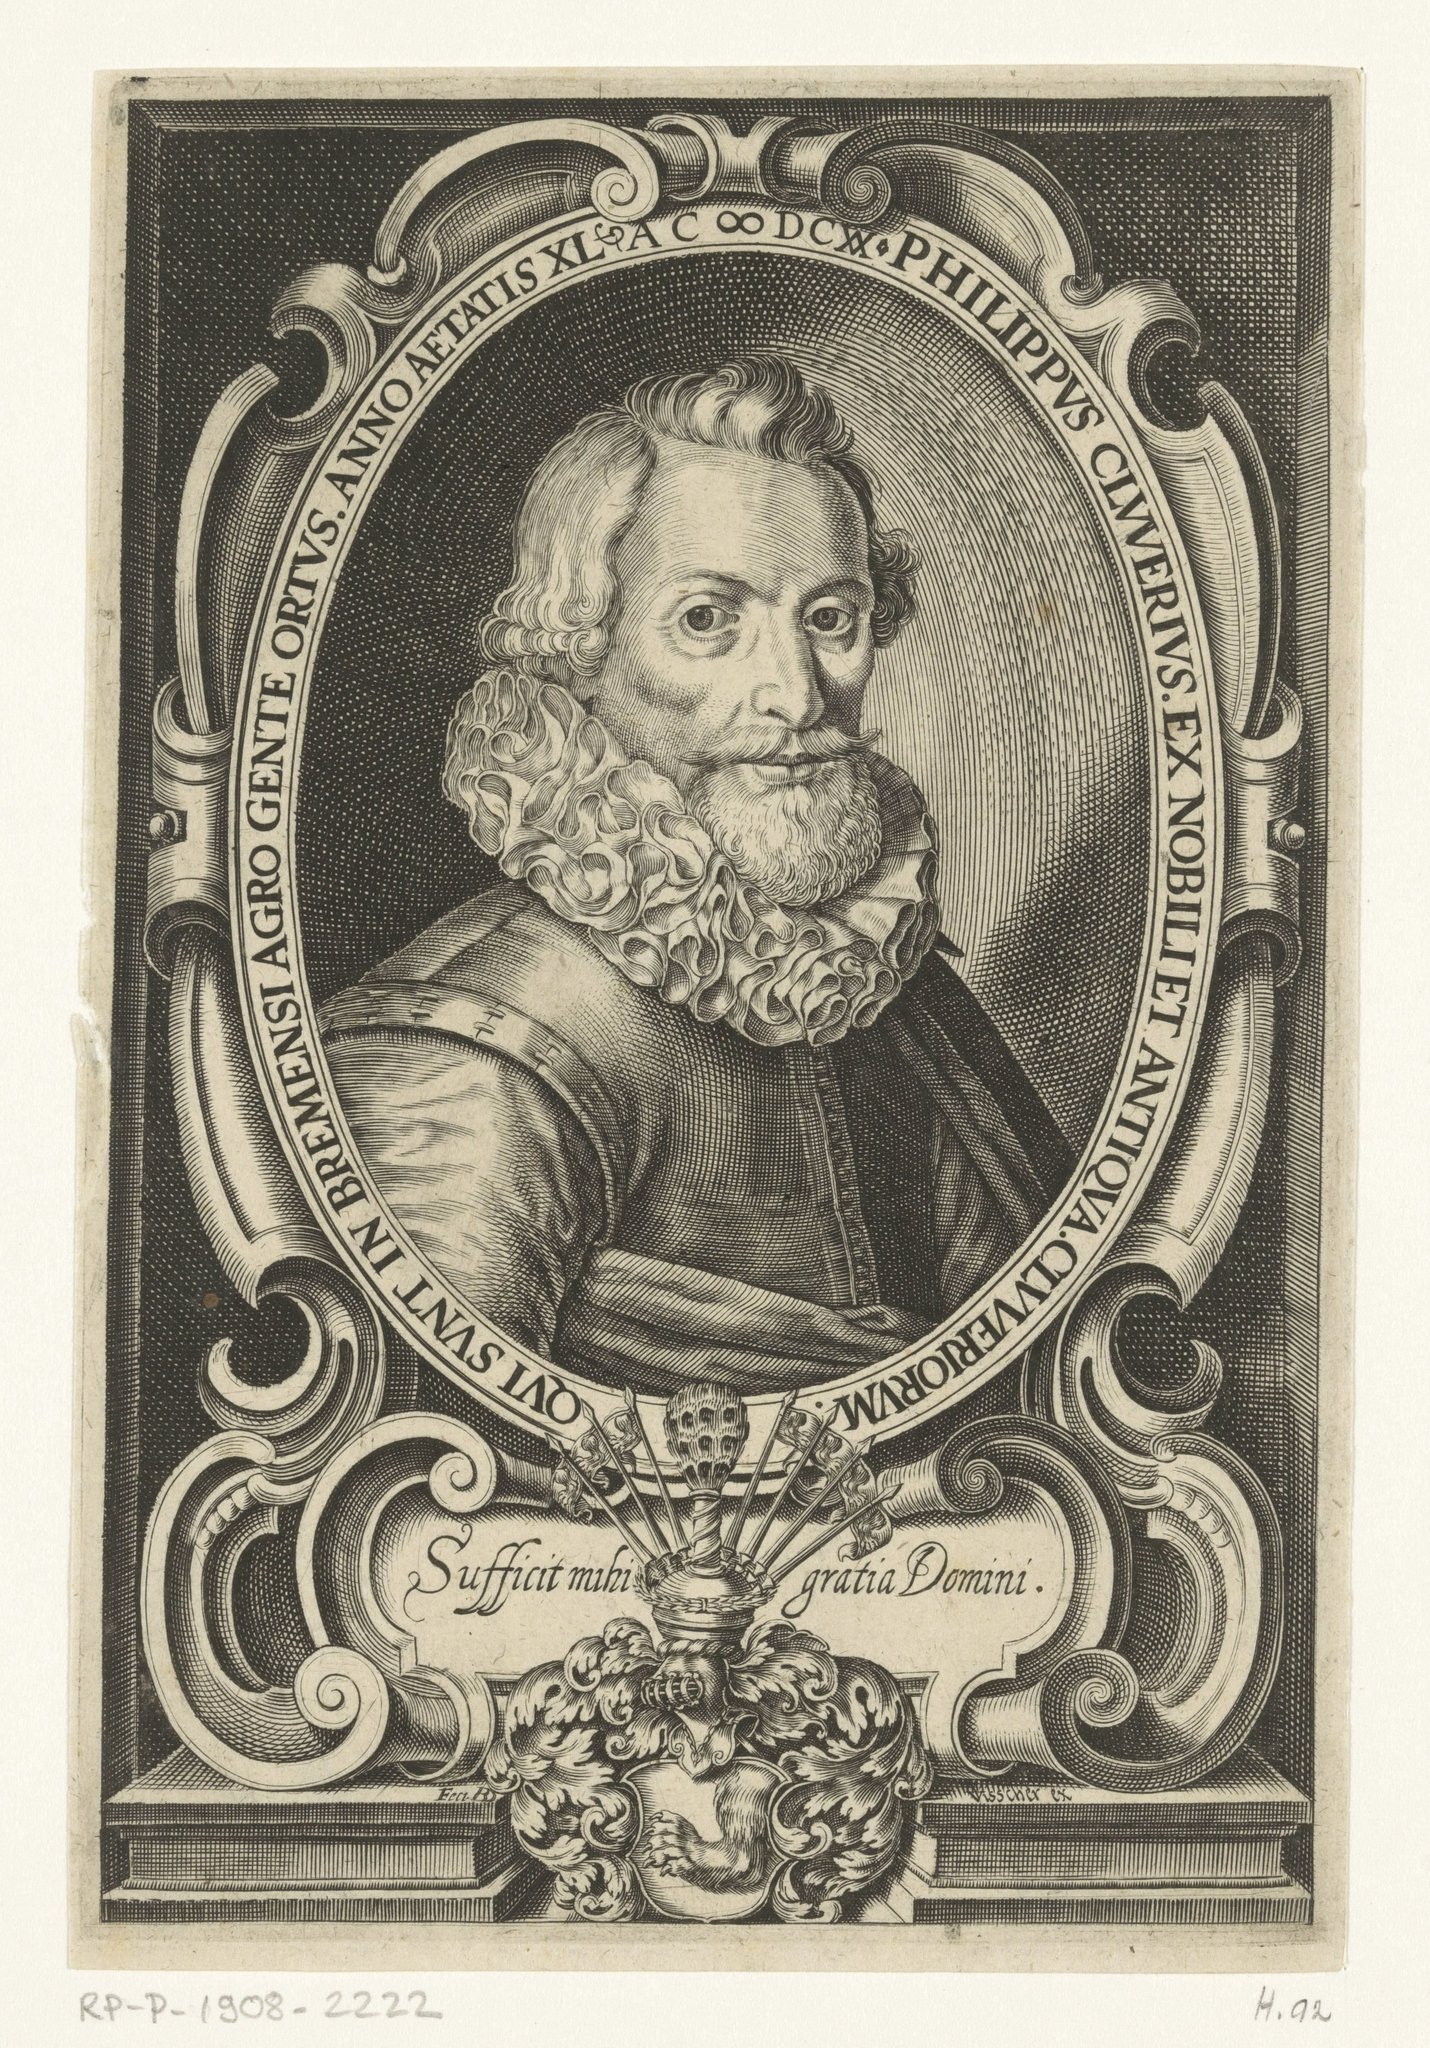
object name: print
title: Portret van de geograaf Philippus Cluverius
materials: paper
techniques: engraving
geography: amsterdam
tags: leiden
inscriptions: collector's mark: Lugt 2228